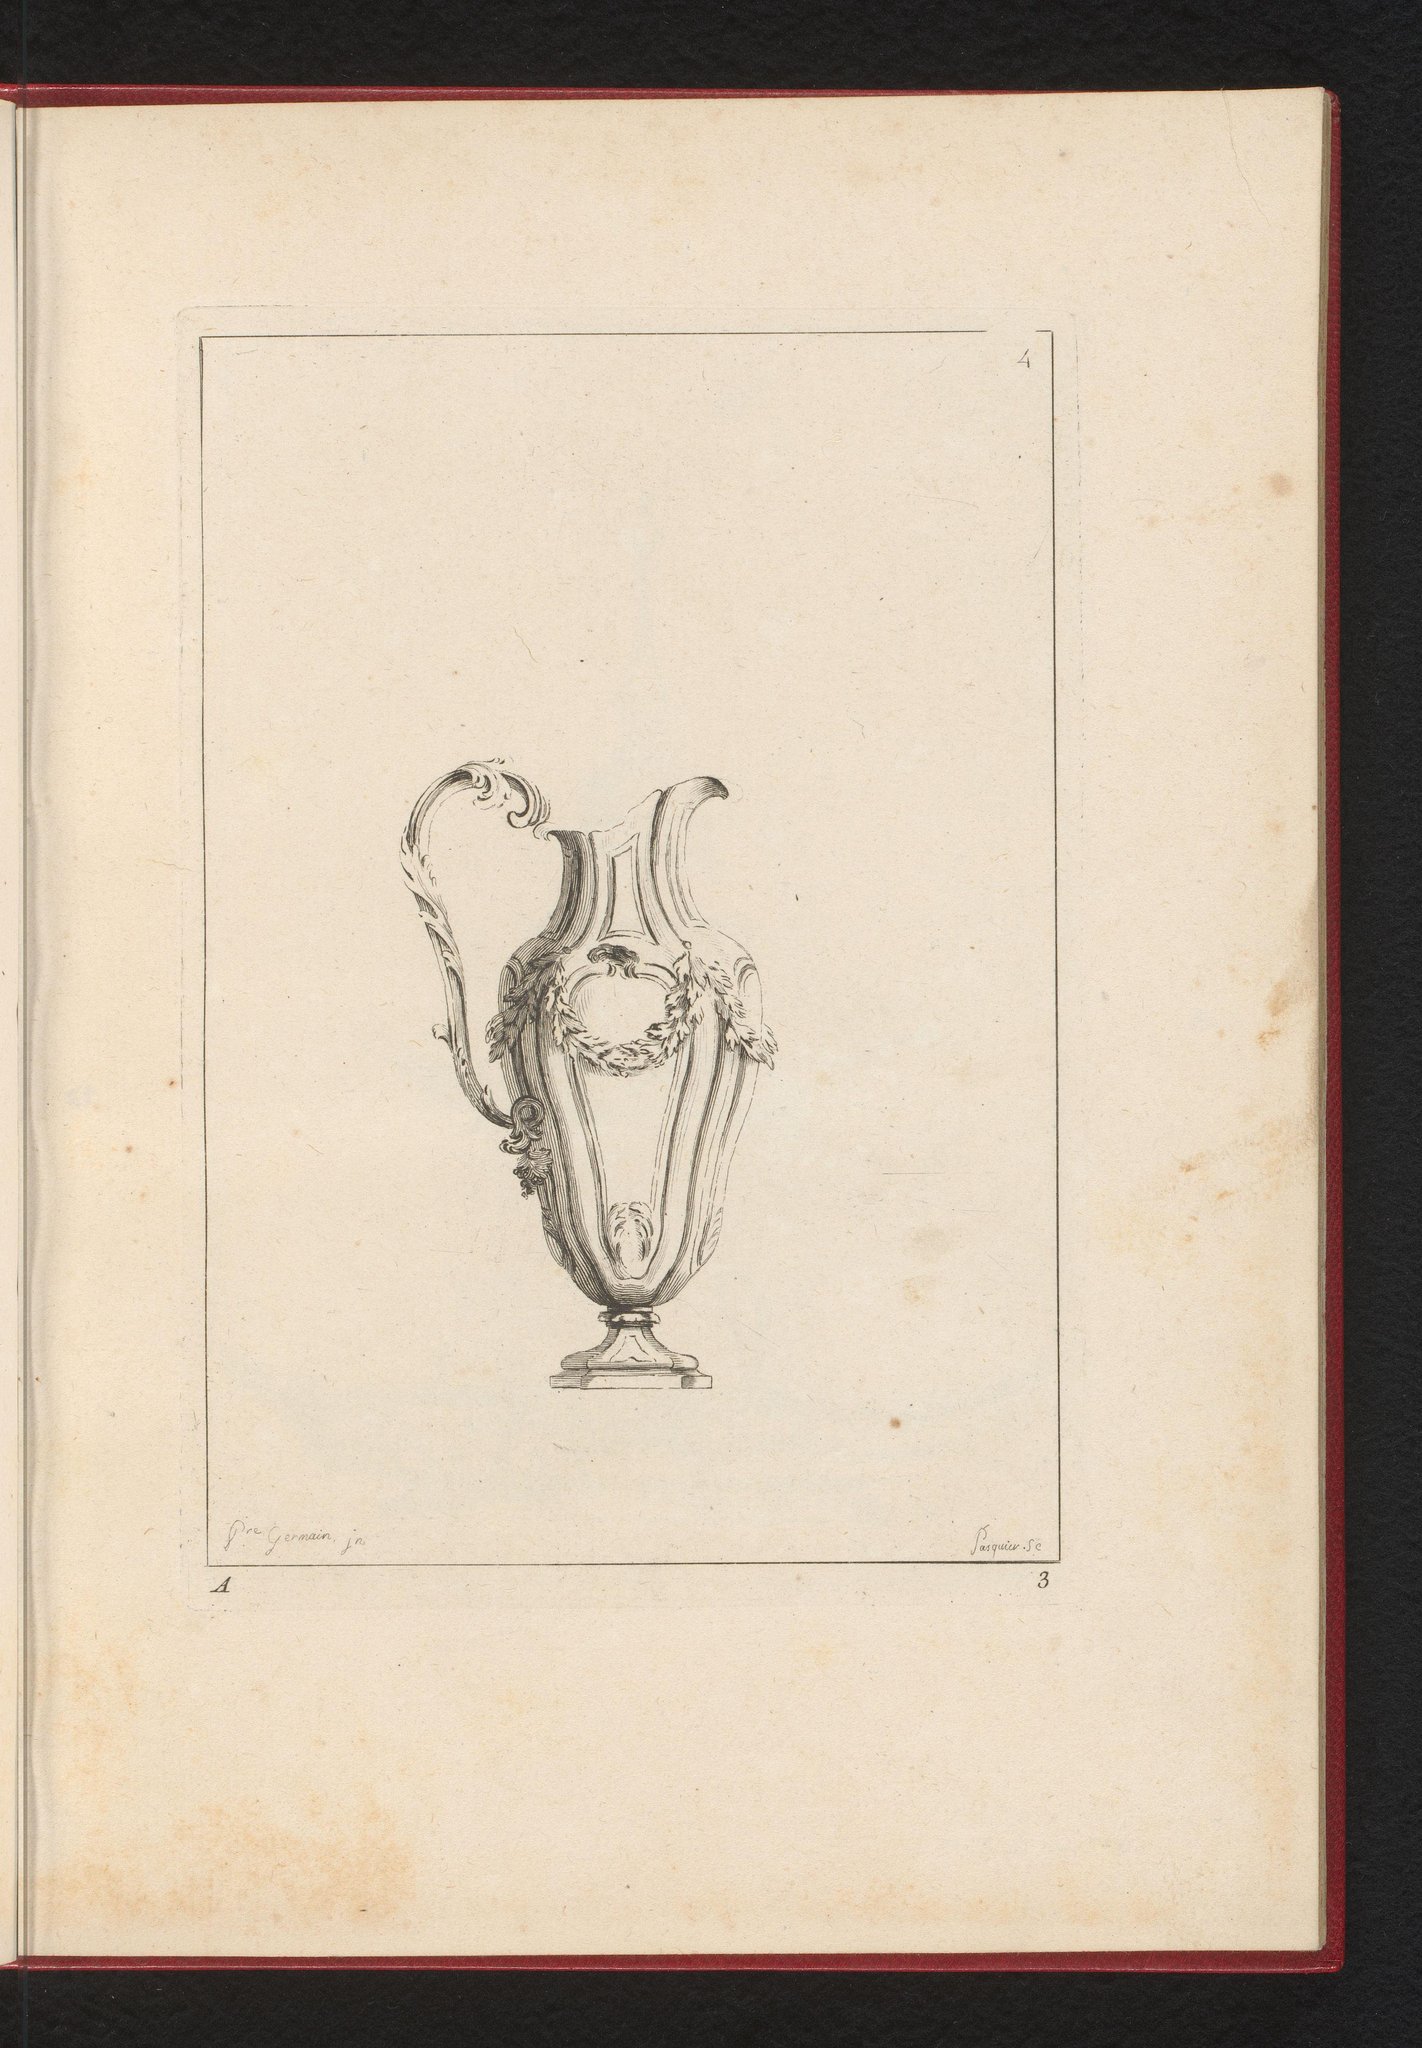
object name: print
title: Zilverwerk en edelsmeedkunst, eerste deel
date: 1748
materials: paper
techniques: etching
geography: paris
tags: ornaments ~ art, cruets and basin ~ communion ware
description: Een aantal van de objecten in deze reeks heeft een eigen ondertitel, die verwijst naar genummerde 'cahiers' (afleveringen) waarin de prenten werden uitgegeven. Het is onduidelijk welke objecten recies bij welke aflevering horen. Daarom is die ondertitel enkel verwerkt bij de prent waarop die voorkomt.